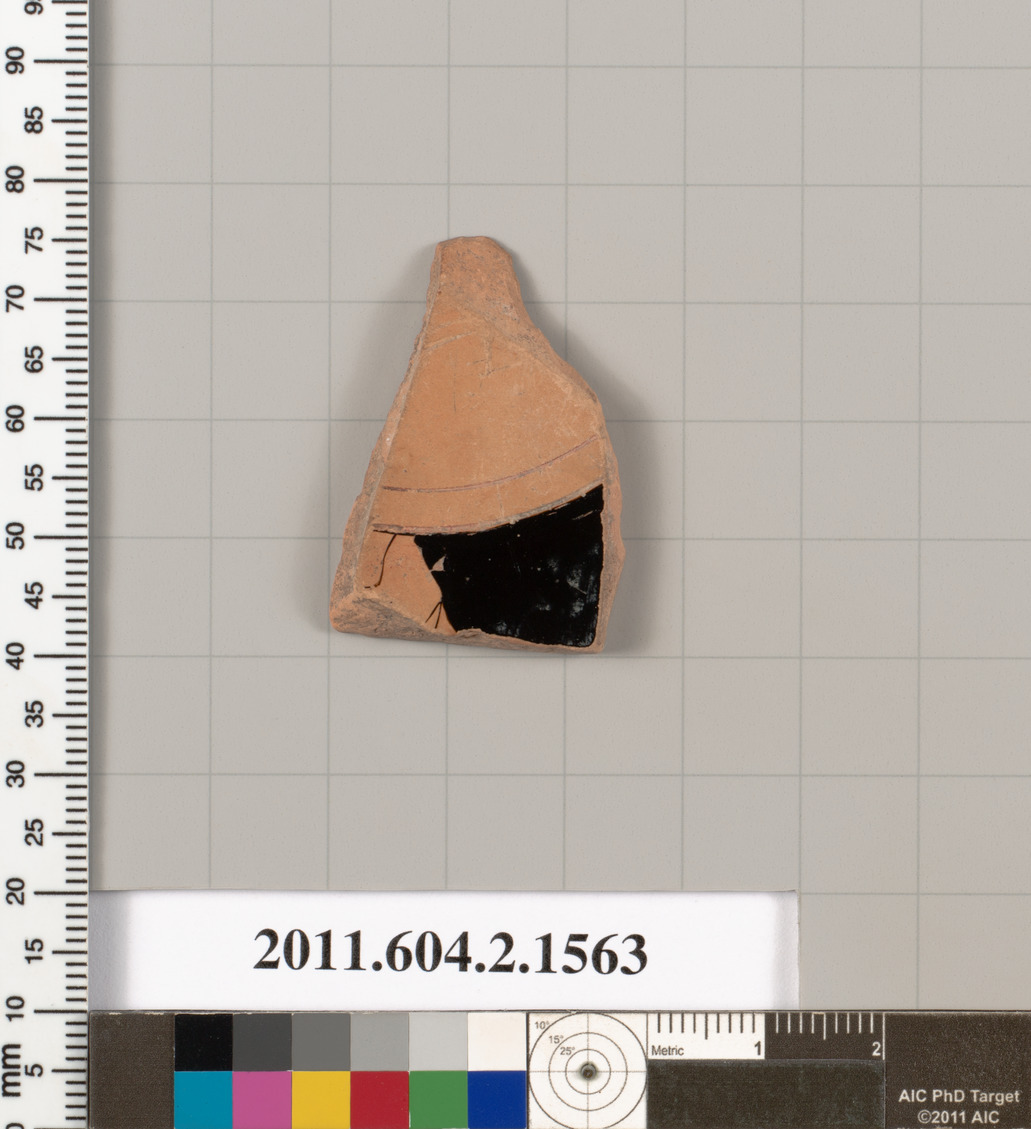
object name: skyphos fragment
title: Terracotta fragment of a skyphos (deep drinking cup)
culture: greek, attic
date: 460-440 BCE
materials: terracotta